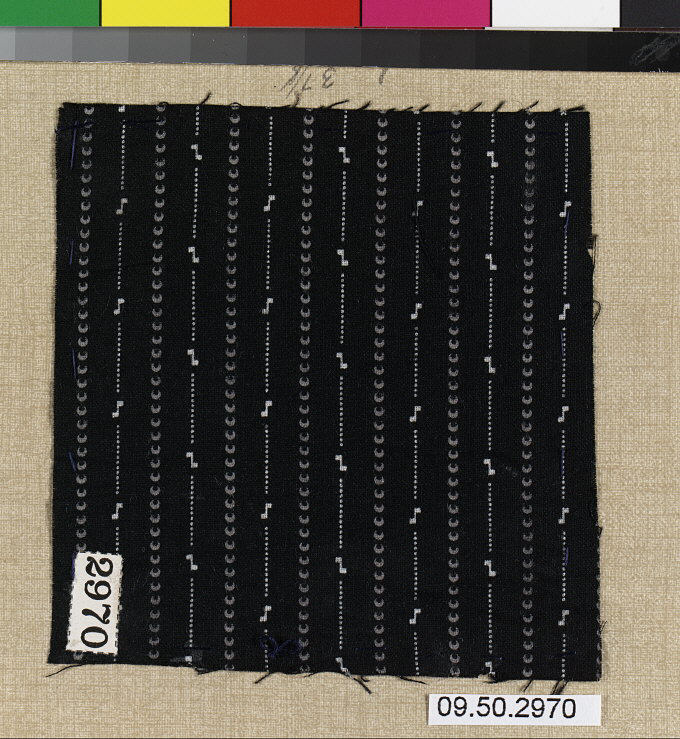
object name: piece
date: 1801-1900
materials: cotton